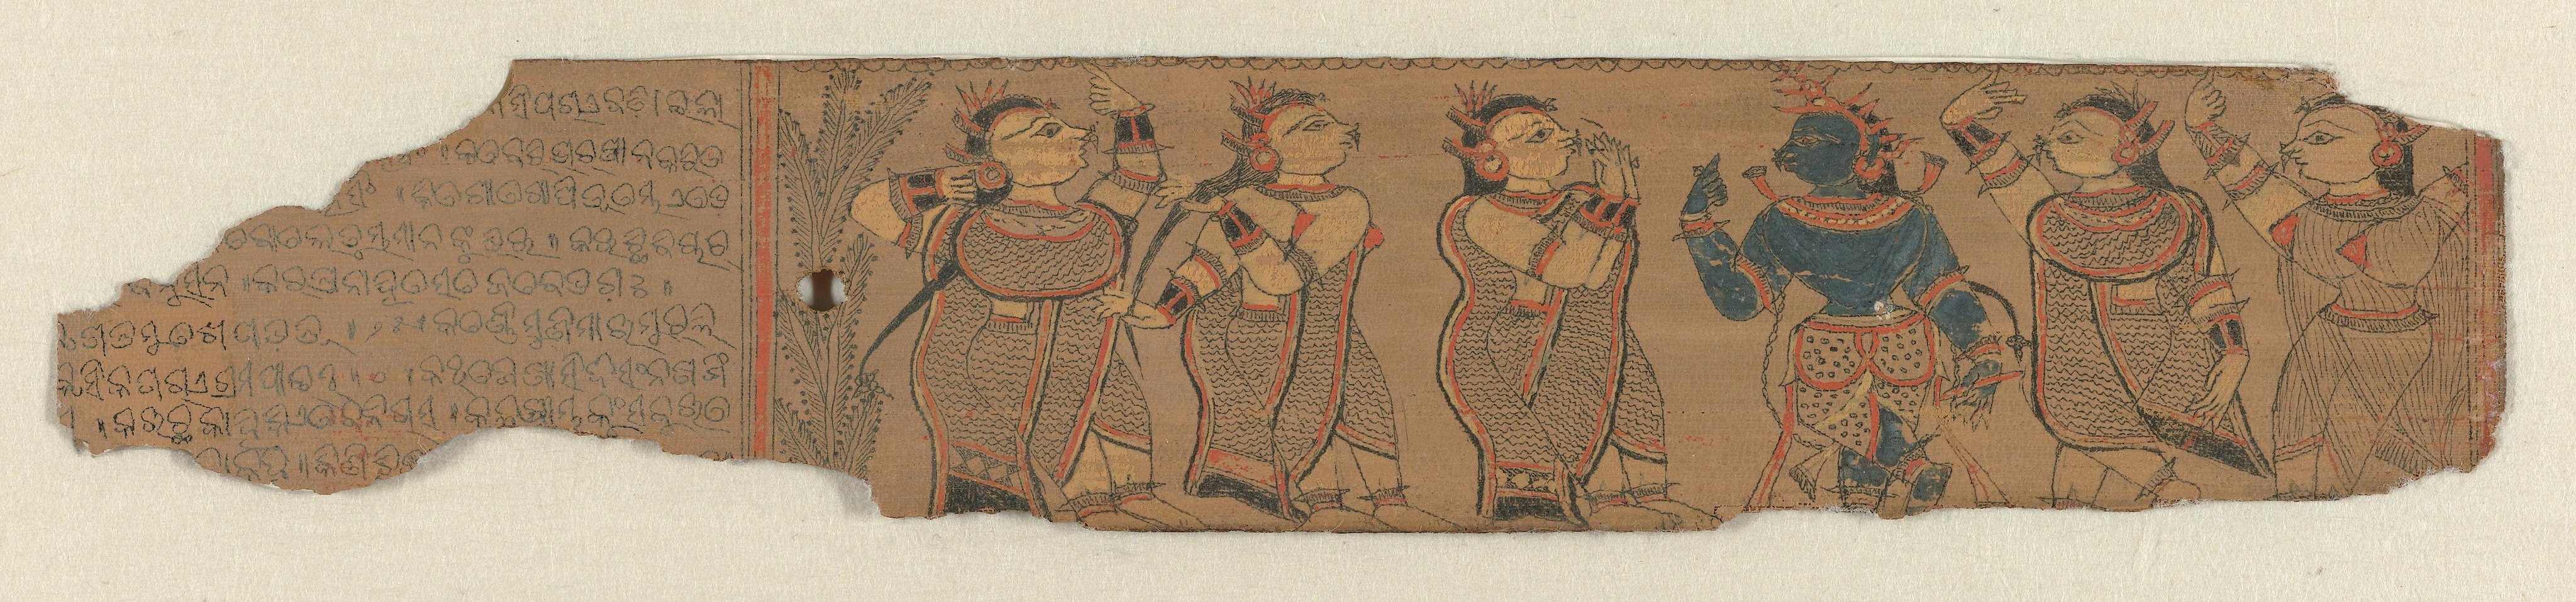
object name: drawing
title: Krishna tussen vijf dames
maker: Anonymous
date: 1800-1900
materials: cardboard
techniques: brush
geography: odisha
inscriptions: inscription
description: Op het onregelmatige stukje karton is het grootste deel gewijd aan een scène van Krishna tussen de vijf dames uit de processie op vorige bladen, drie links en twee rechts van hem; links van de rode bies is nog een gedeelte tekst te zien. Onregelmatig stuk karton met links ponsgaatje en aan de linkerkant uitlopend in een smallere punt.